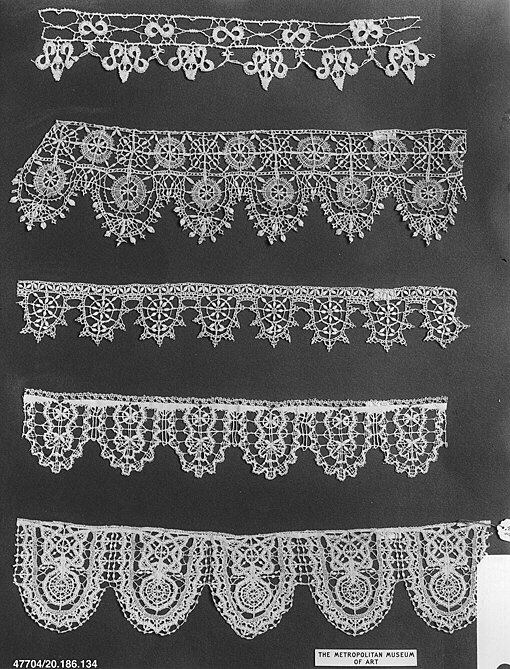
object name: edging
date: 1501-1700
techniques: lace